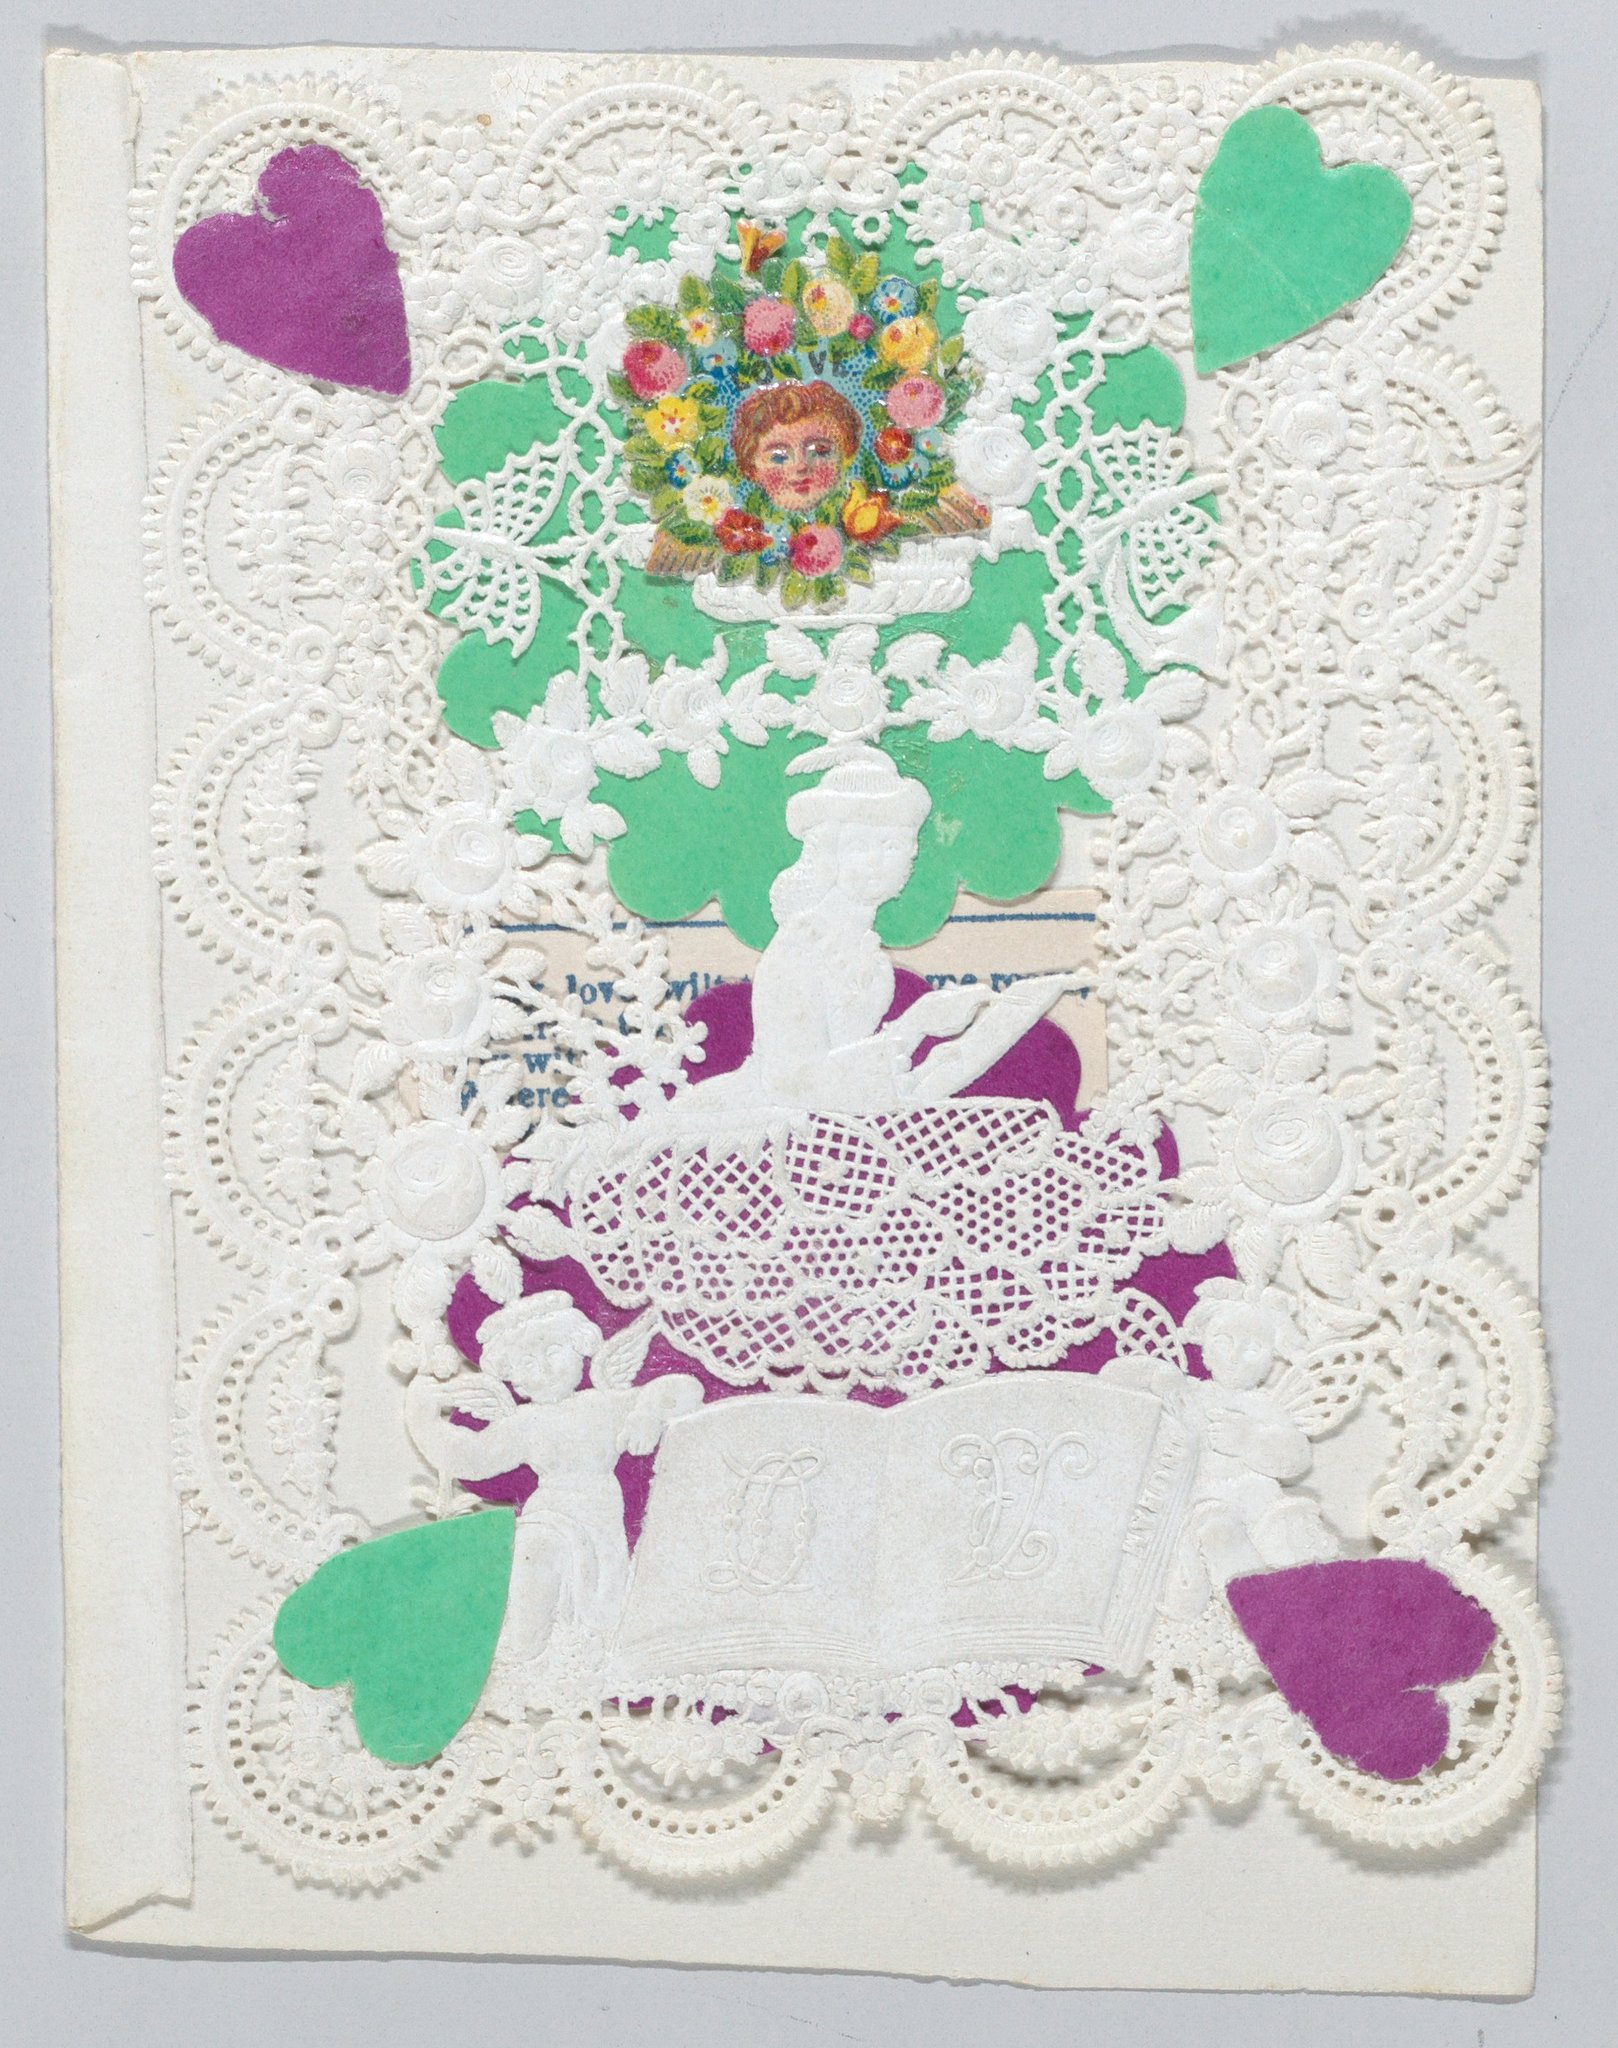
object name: valentine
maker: esther howland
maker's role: artist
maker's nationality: american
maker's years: 1828-1904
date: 1847-1870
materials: lace, paper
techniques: chromolithography, embossing, open work